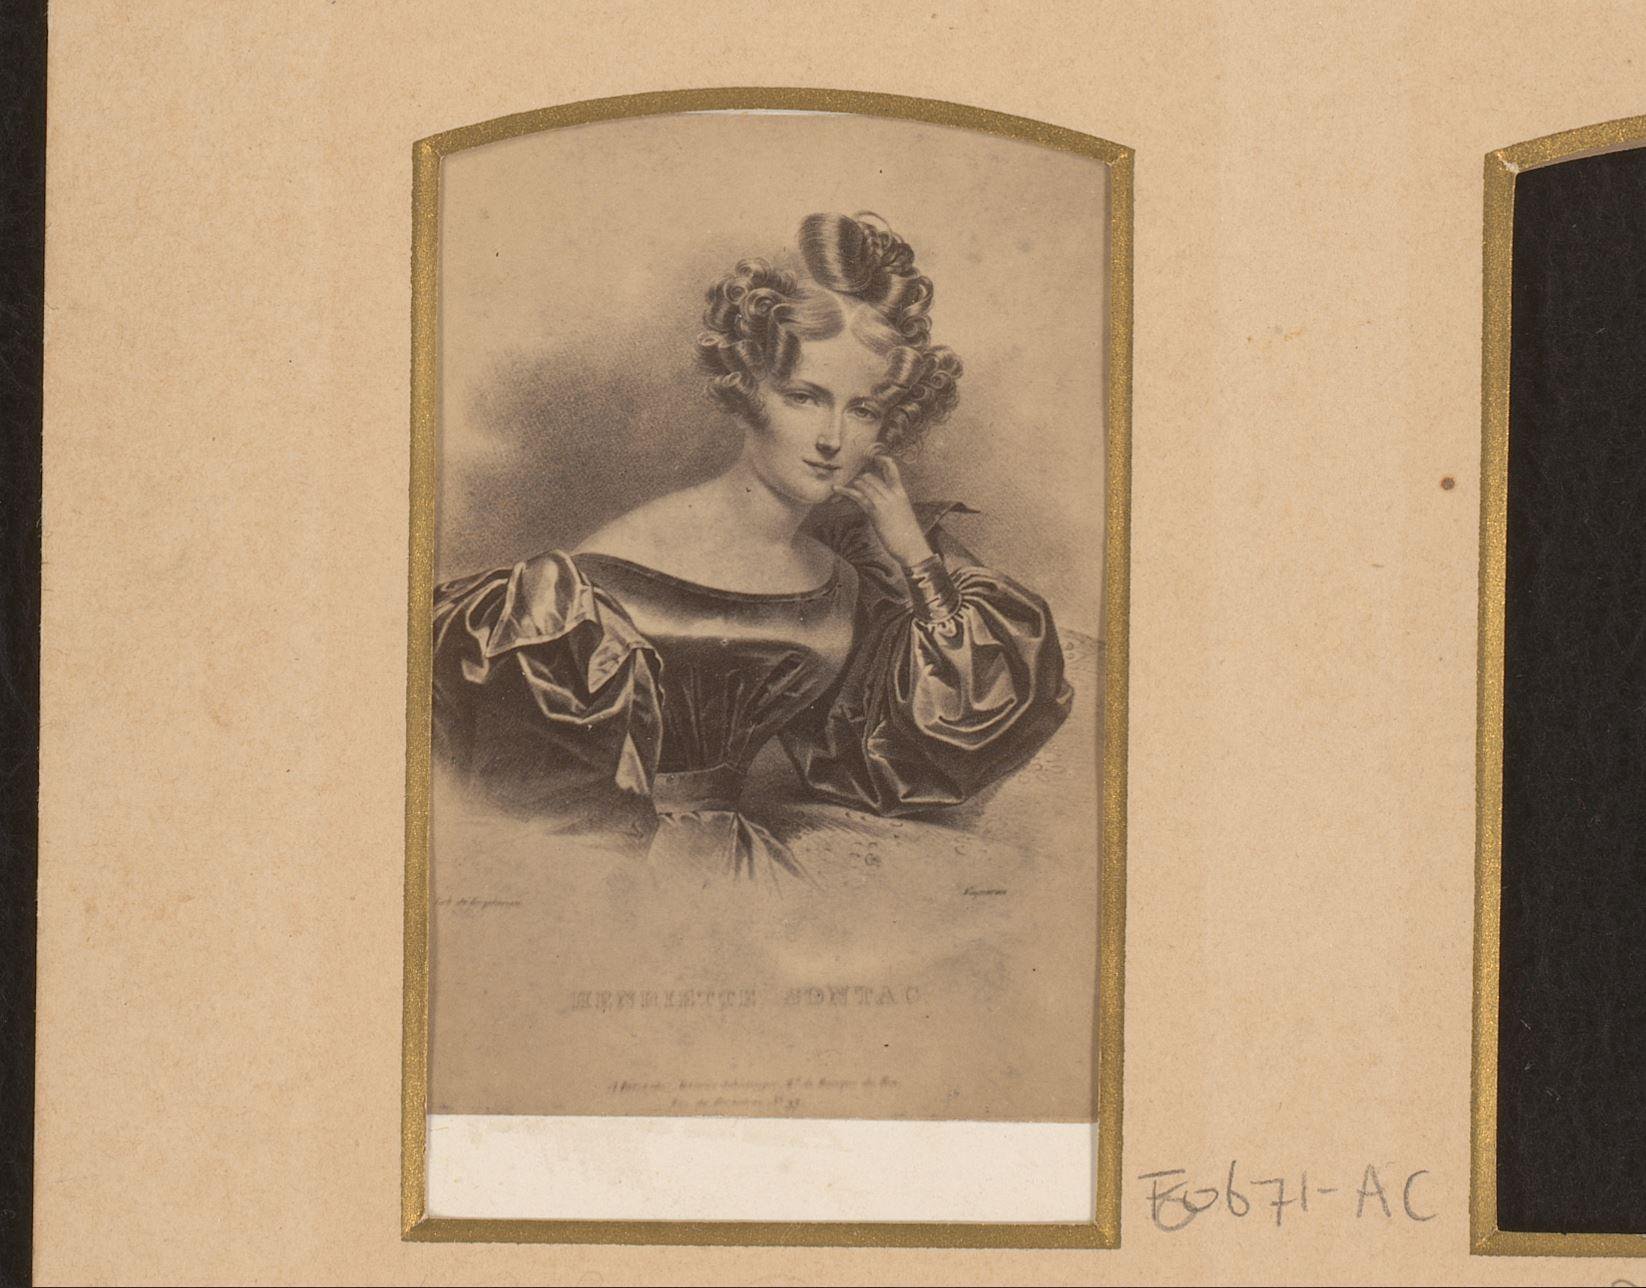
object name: photograph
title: Fotoreproductie van een getekend portret van Henriëtte Sontag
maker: pierre petit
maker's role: fotograaf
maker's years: 1832-1909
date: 1860-1900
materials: cardboard, photographic support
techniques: albumen print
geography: paris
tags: historical persons - bb - woman, opera-singer (female)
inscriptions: inscription: ‘Paris Besançon/ Pierre Petit/ Photographe/ 31, Place Cadet/ Paris’, name: ‘Henriette Sontag’